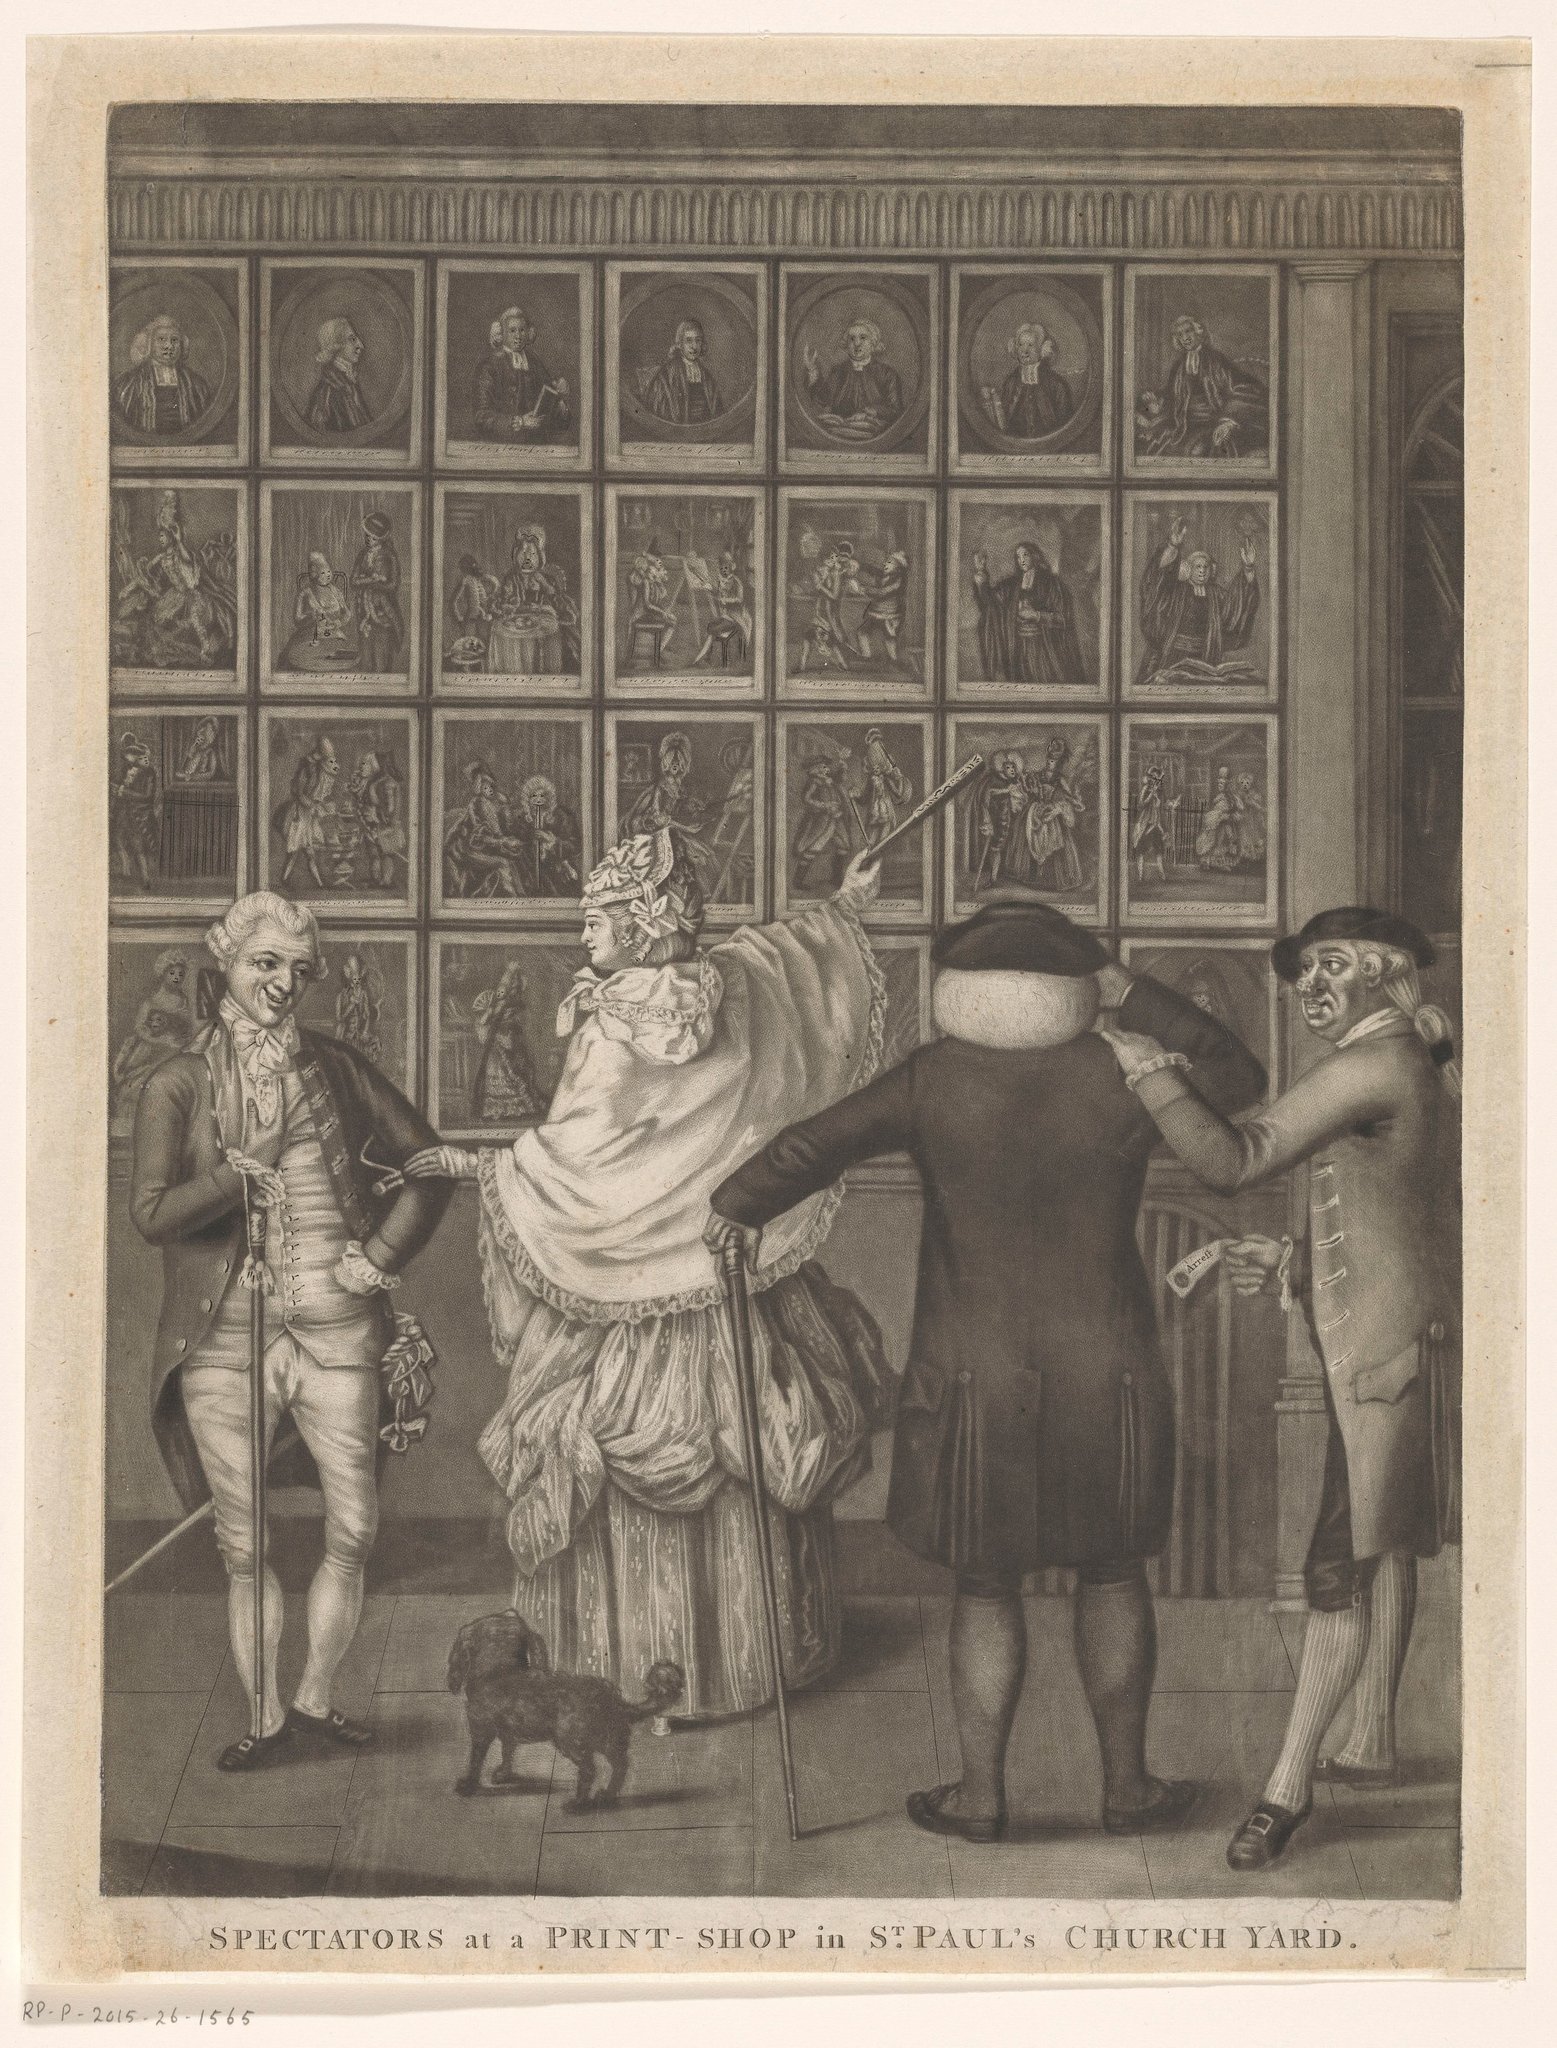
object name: print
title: Vier personen voor de etalage van prenthandel Carrington Bowles te Londen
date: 1774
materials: paper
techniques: mezzotint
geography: london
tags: print, e.g.: engraving, etching, lithograph, art dealer (+ graphic arts), fan, fashion, political caricatures and satires, dog, shop-window, show-window, london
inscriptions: collector's mark: Lugt 2228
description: Links een man en een vrouw in modieuze kleding; tussen hen in een hondje. De vrouw wijst met een gesloten waaier naar de prenten in de etalage. Rechts staat een man met een stok. Een man met een arrestatiebevel legt zijn hand op zijn schouder.